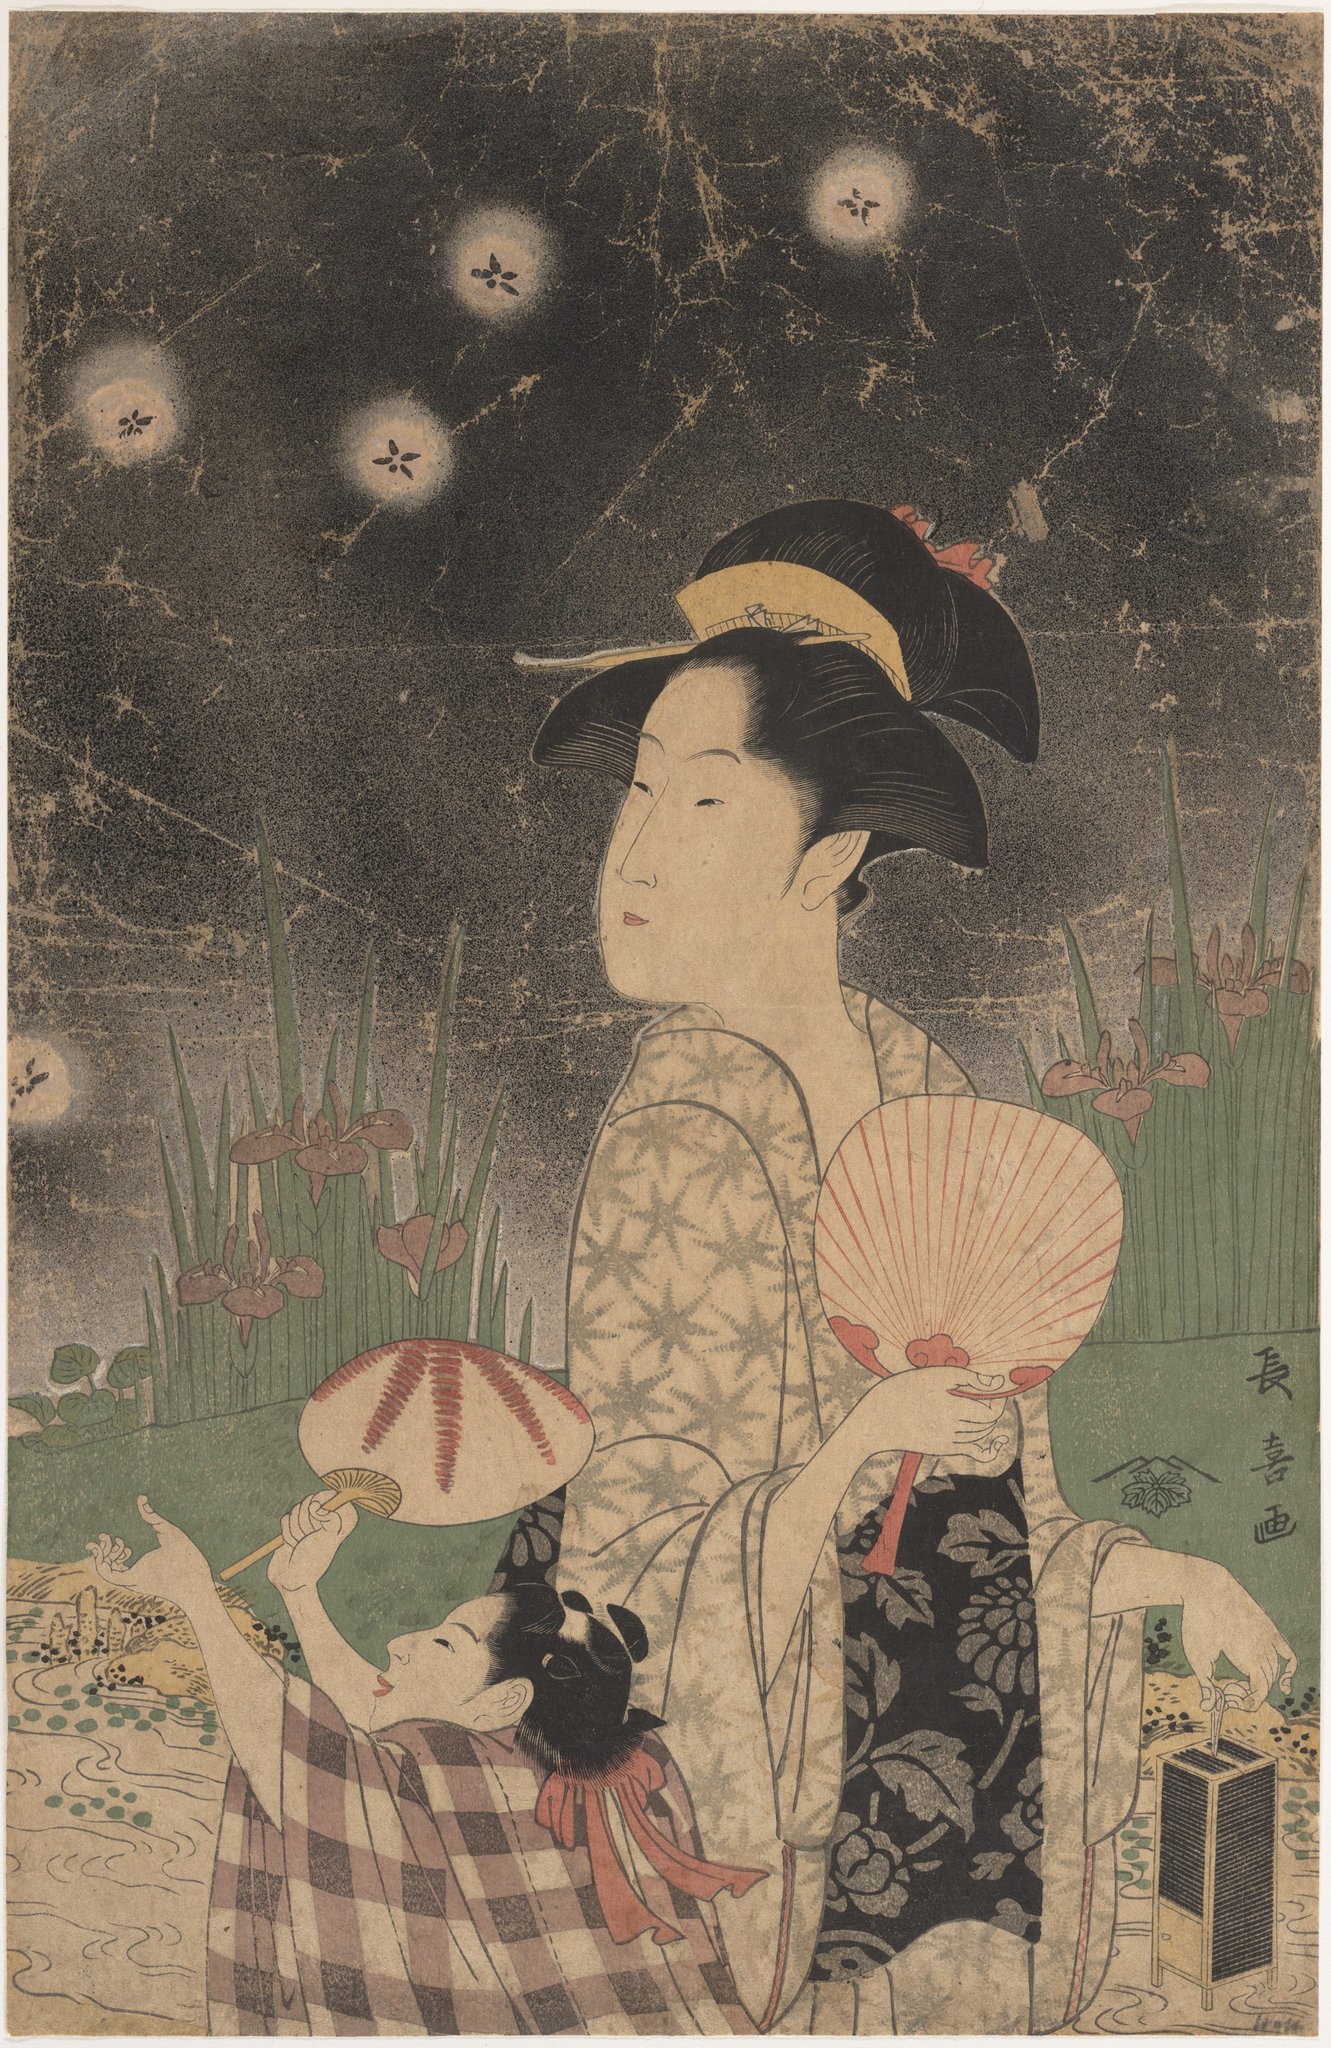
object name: print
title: Woman and Child Catching Fireflies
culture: japanese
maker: eishōsai chōki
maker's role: artist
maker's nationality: japanese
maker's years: 1700-1900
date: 1793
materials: ink, paper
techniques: woodblock print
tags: fans,girls,women,insects